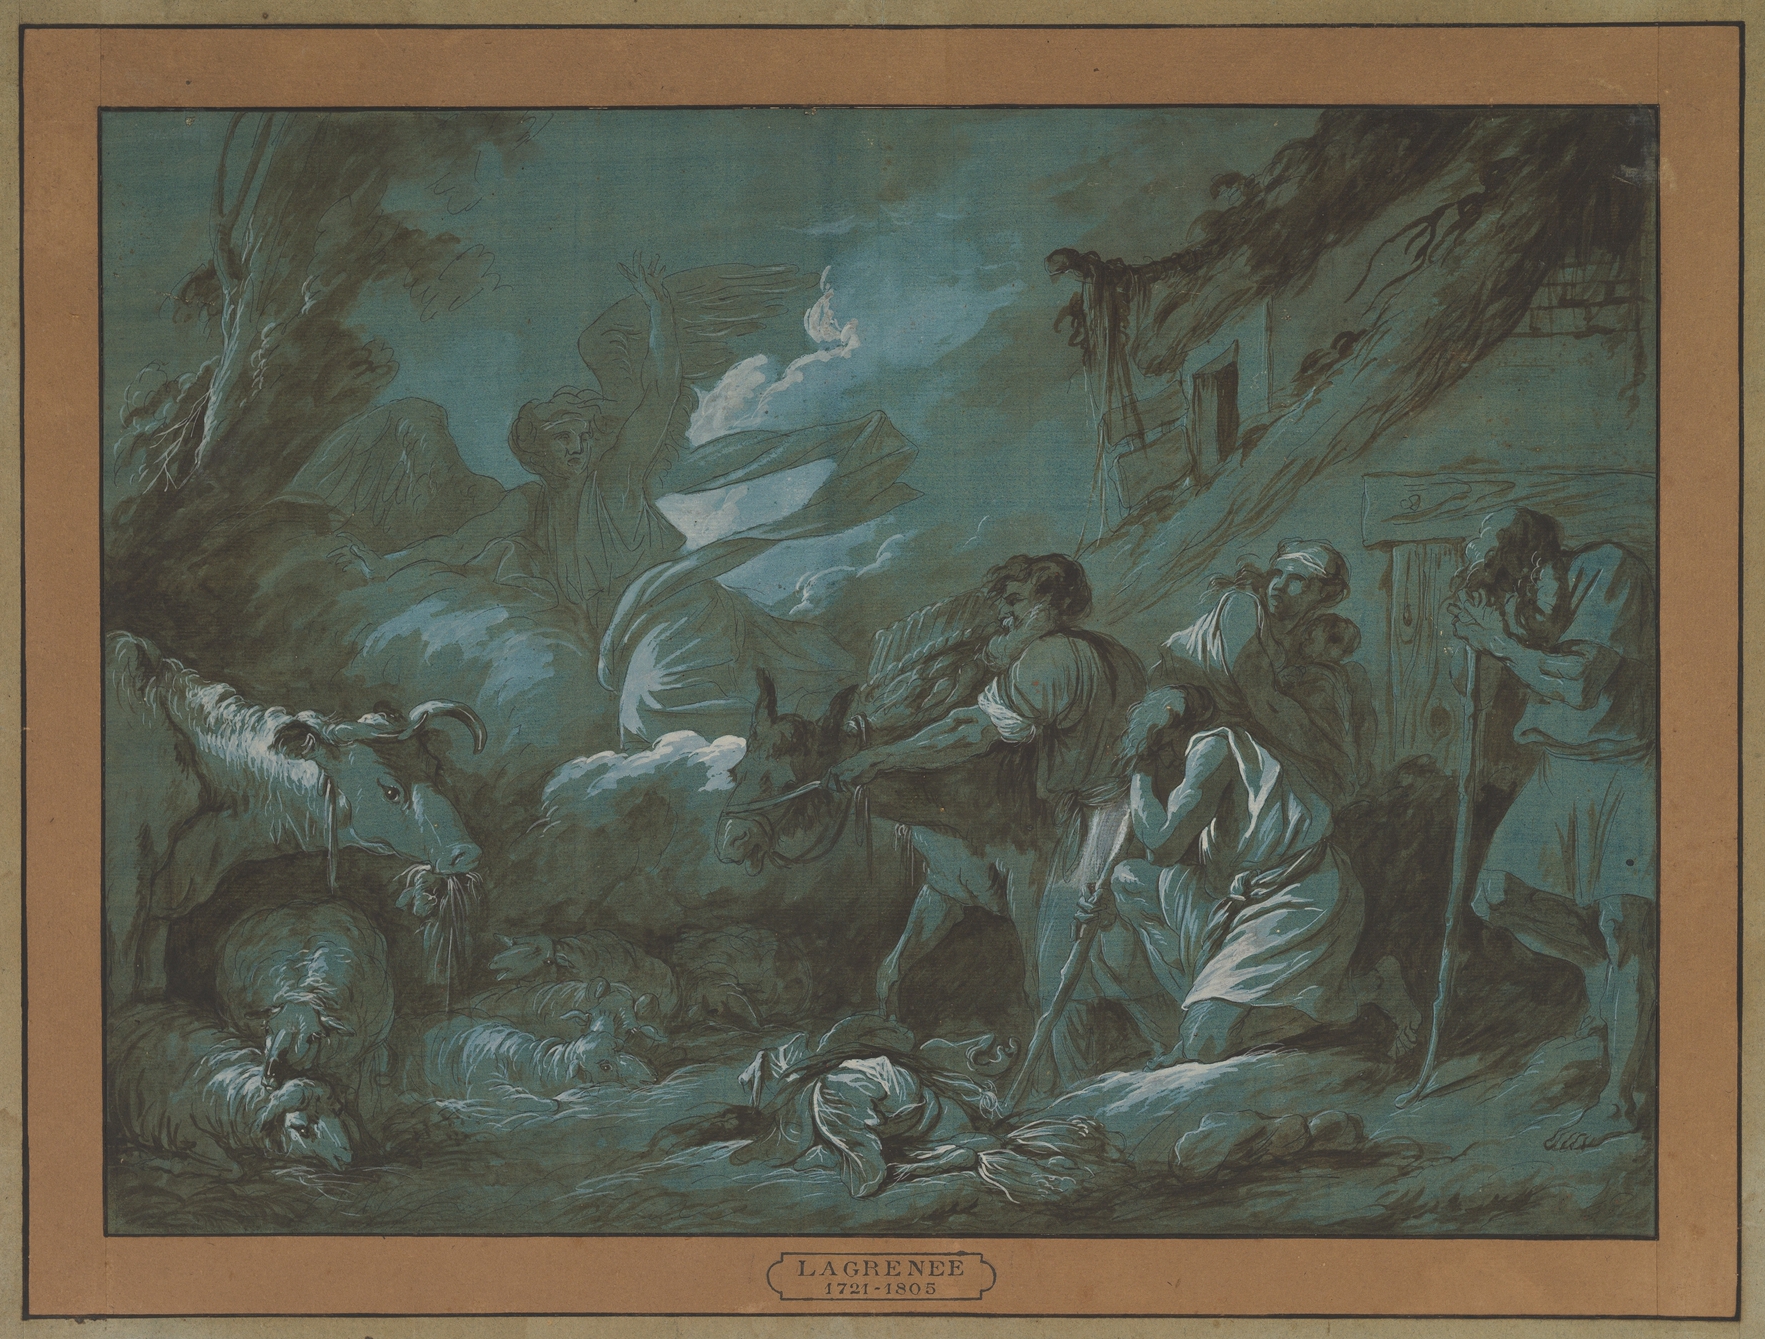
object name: drawing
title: Annunciation to the Shepherds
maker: jean jacques lagrenée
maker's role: artist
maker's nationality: french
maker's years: 1739-1821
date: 1775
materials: ink, paper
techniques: brush, heightening, pen, wash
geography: france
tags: infants,men,bulls,annunciation,shepherds